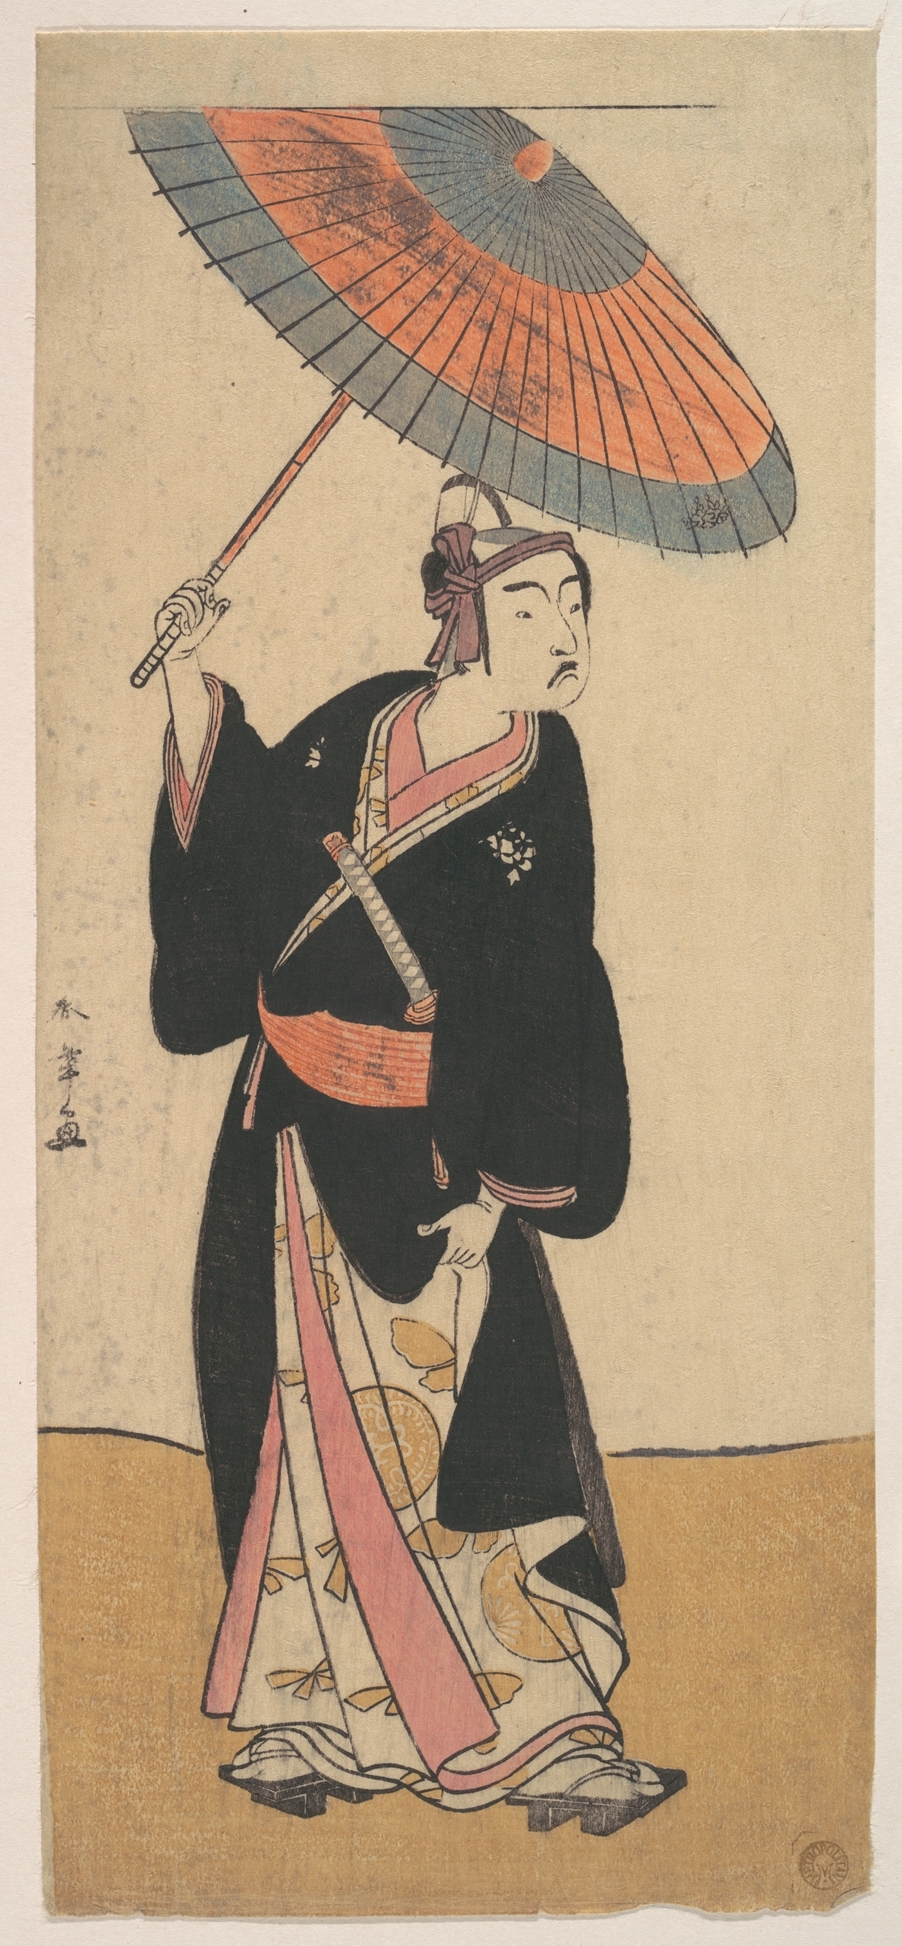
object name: woodblock print nishiki e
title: The Third Ichikawa Yaozo in the Role of Otokodate Sukeroku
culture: japanese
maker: katsukawa shunshō 勝川春章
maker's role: artist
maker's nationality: japanese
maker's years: 1726-1792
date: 1784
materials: ink, paper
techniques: nishiki e, woodblock print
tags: men,actors,umbrellas